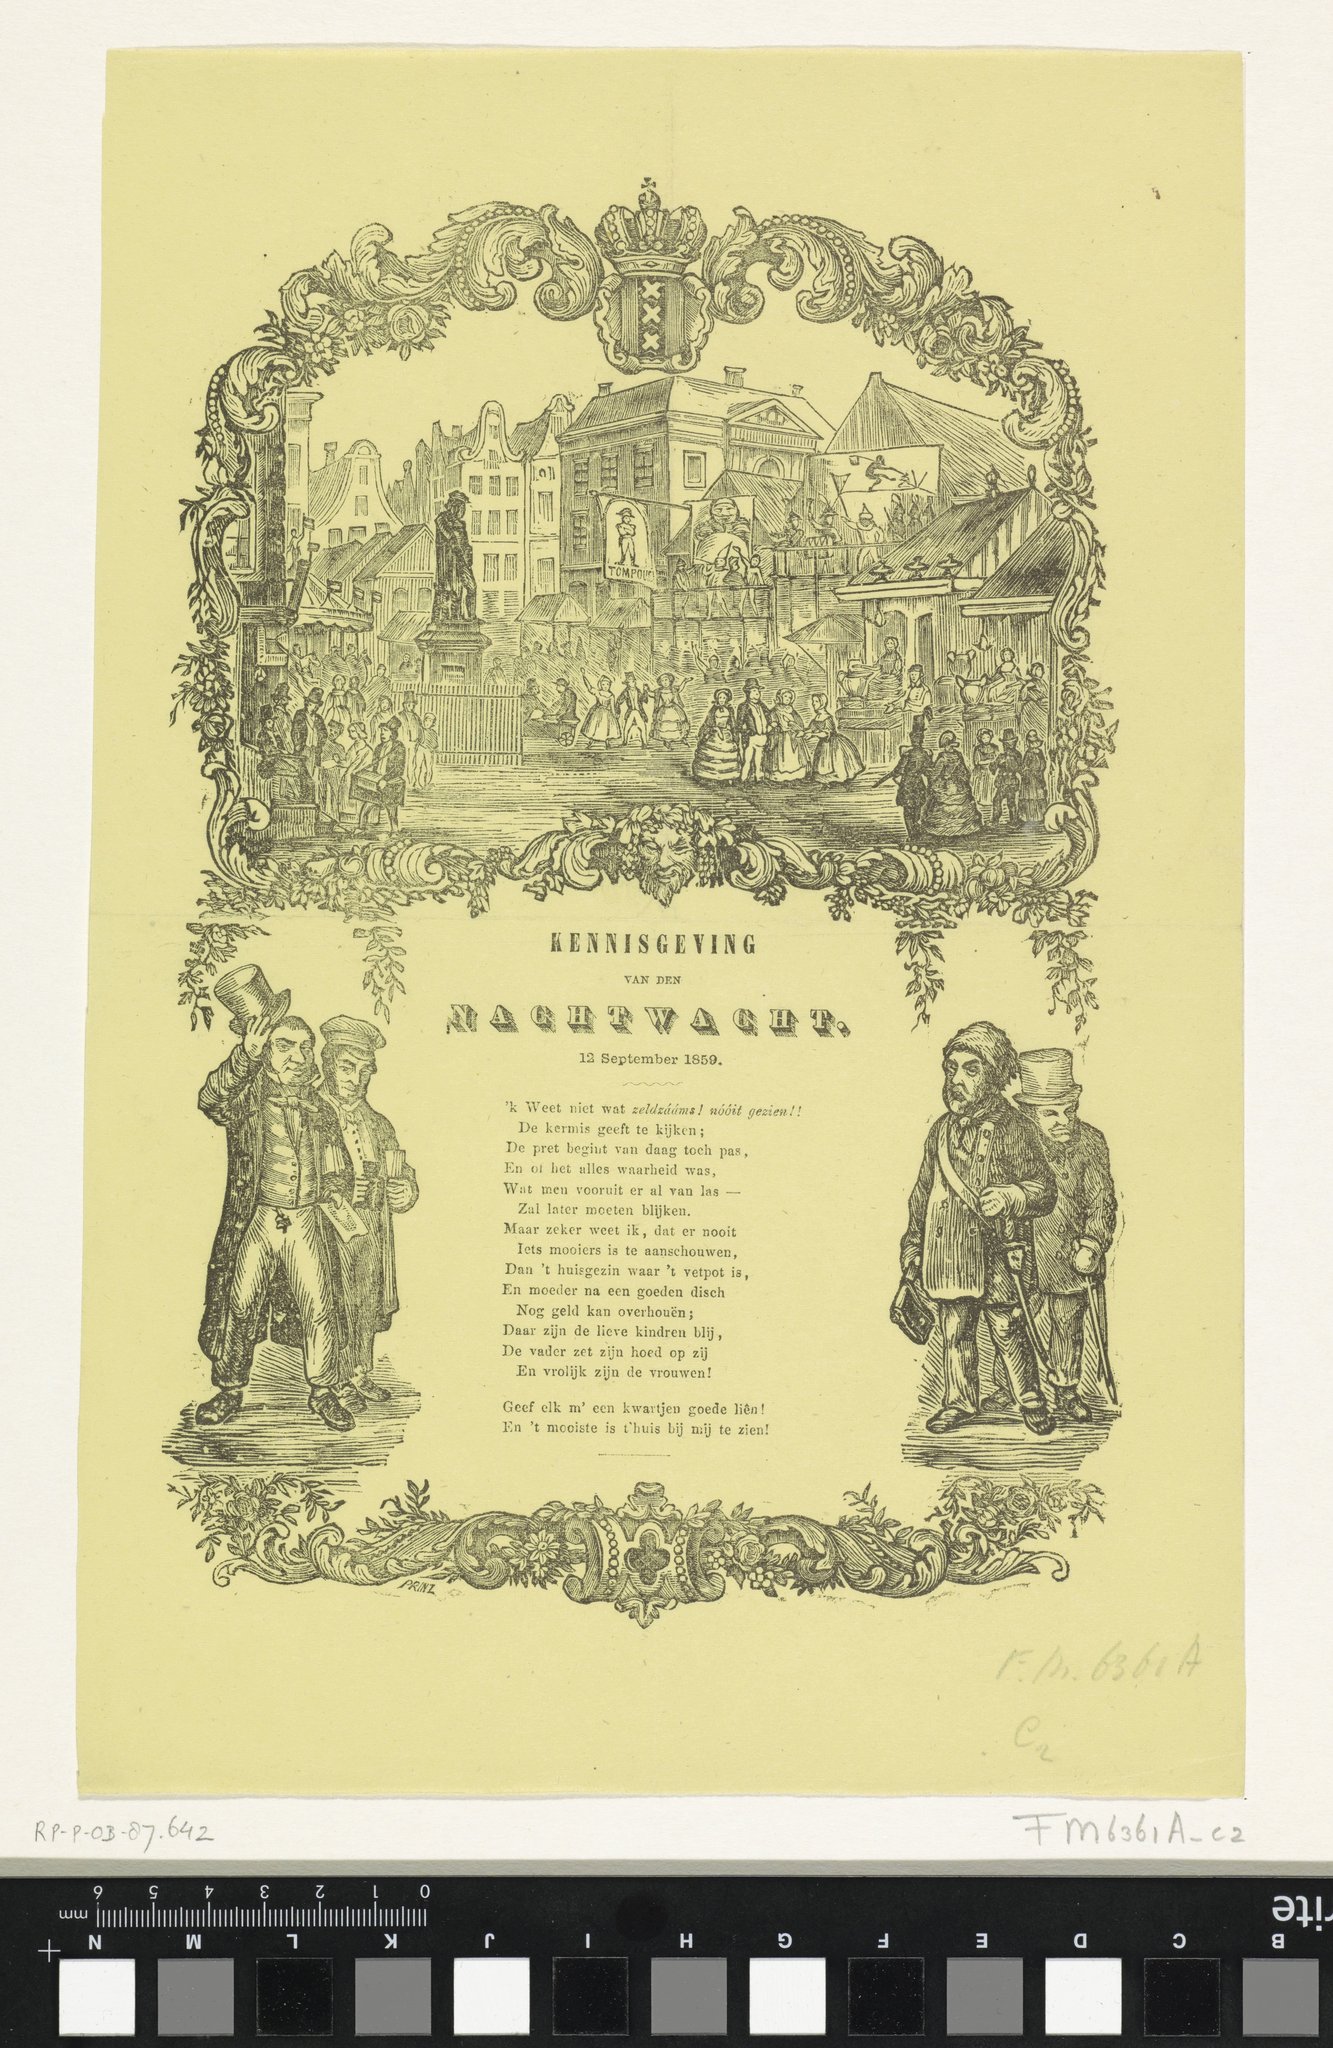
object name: fair print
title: Kermisprent van de Amsterdamse nachtwacht voor het jaar 1859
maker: friedrich robert prinz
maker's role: print maker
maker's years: 1820-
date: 1859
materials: paper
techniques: letterpress printing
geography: netherlands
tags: night patrol, pleasure fair and circus, amsterdam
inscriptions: collector's mark: Lugt 2228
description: Kermisprent van de Amsterdamse nachtwacht (ratelwacht), 12 september 1859. Bovenaan de kermis op de Botermarkt (Rembrandtplein), onder links en rechts leden van de nachtwacht. Centraal een gedicht.